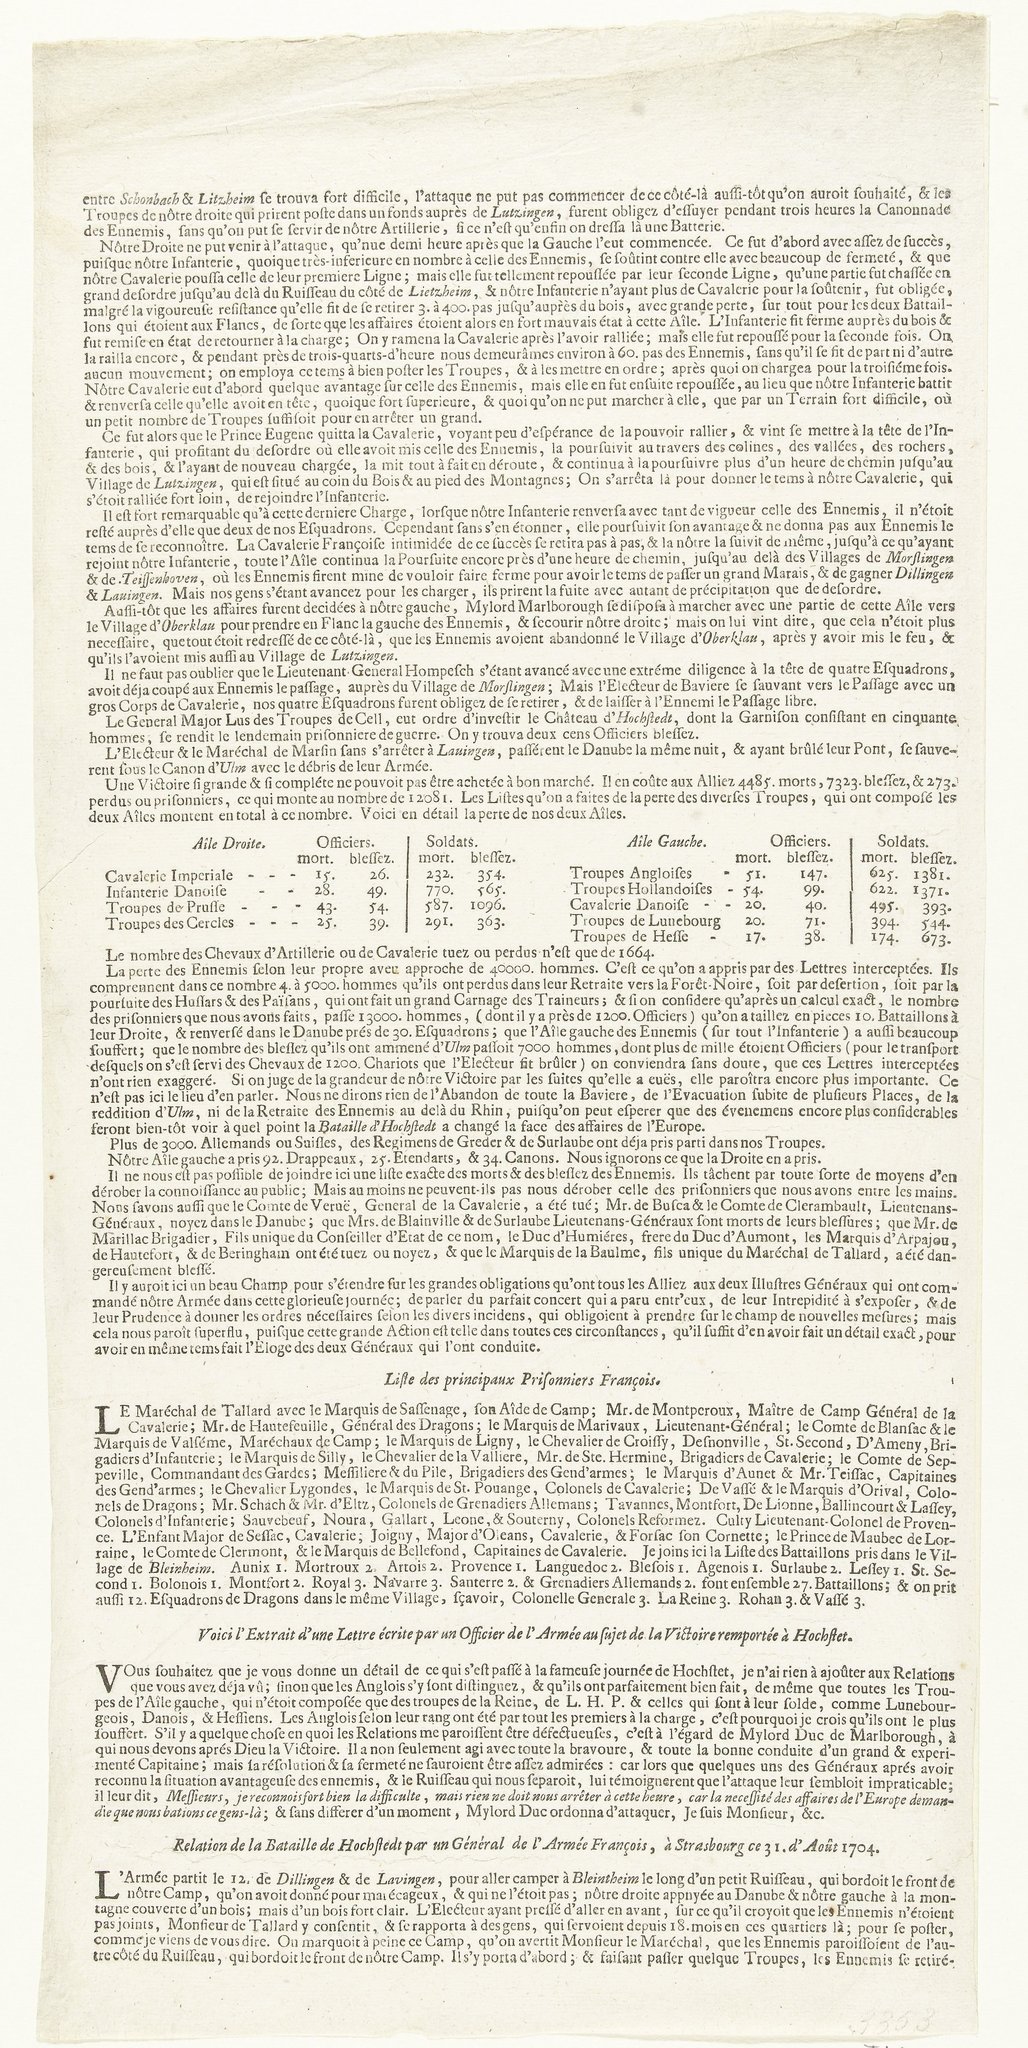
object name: text sheet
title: Deel van een Franse beschrijving van de slag bij Höchstädt, 1704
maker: Anonymous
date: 1704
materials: paper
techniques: letterpress printing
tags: slag bij höchstädt (1704)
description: Tekstblad met een gedeelte van een Franse beschrijving van de slag bij Höchstädt op 13 augustus 1704 waar de Geallieerden de Fransen en de Beiersen versloegen. Behoort bij een (ontbrekende) voorstelling.